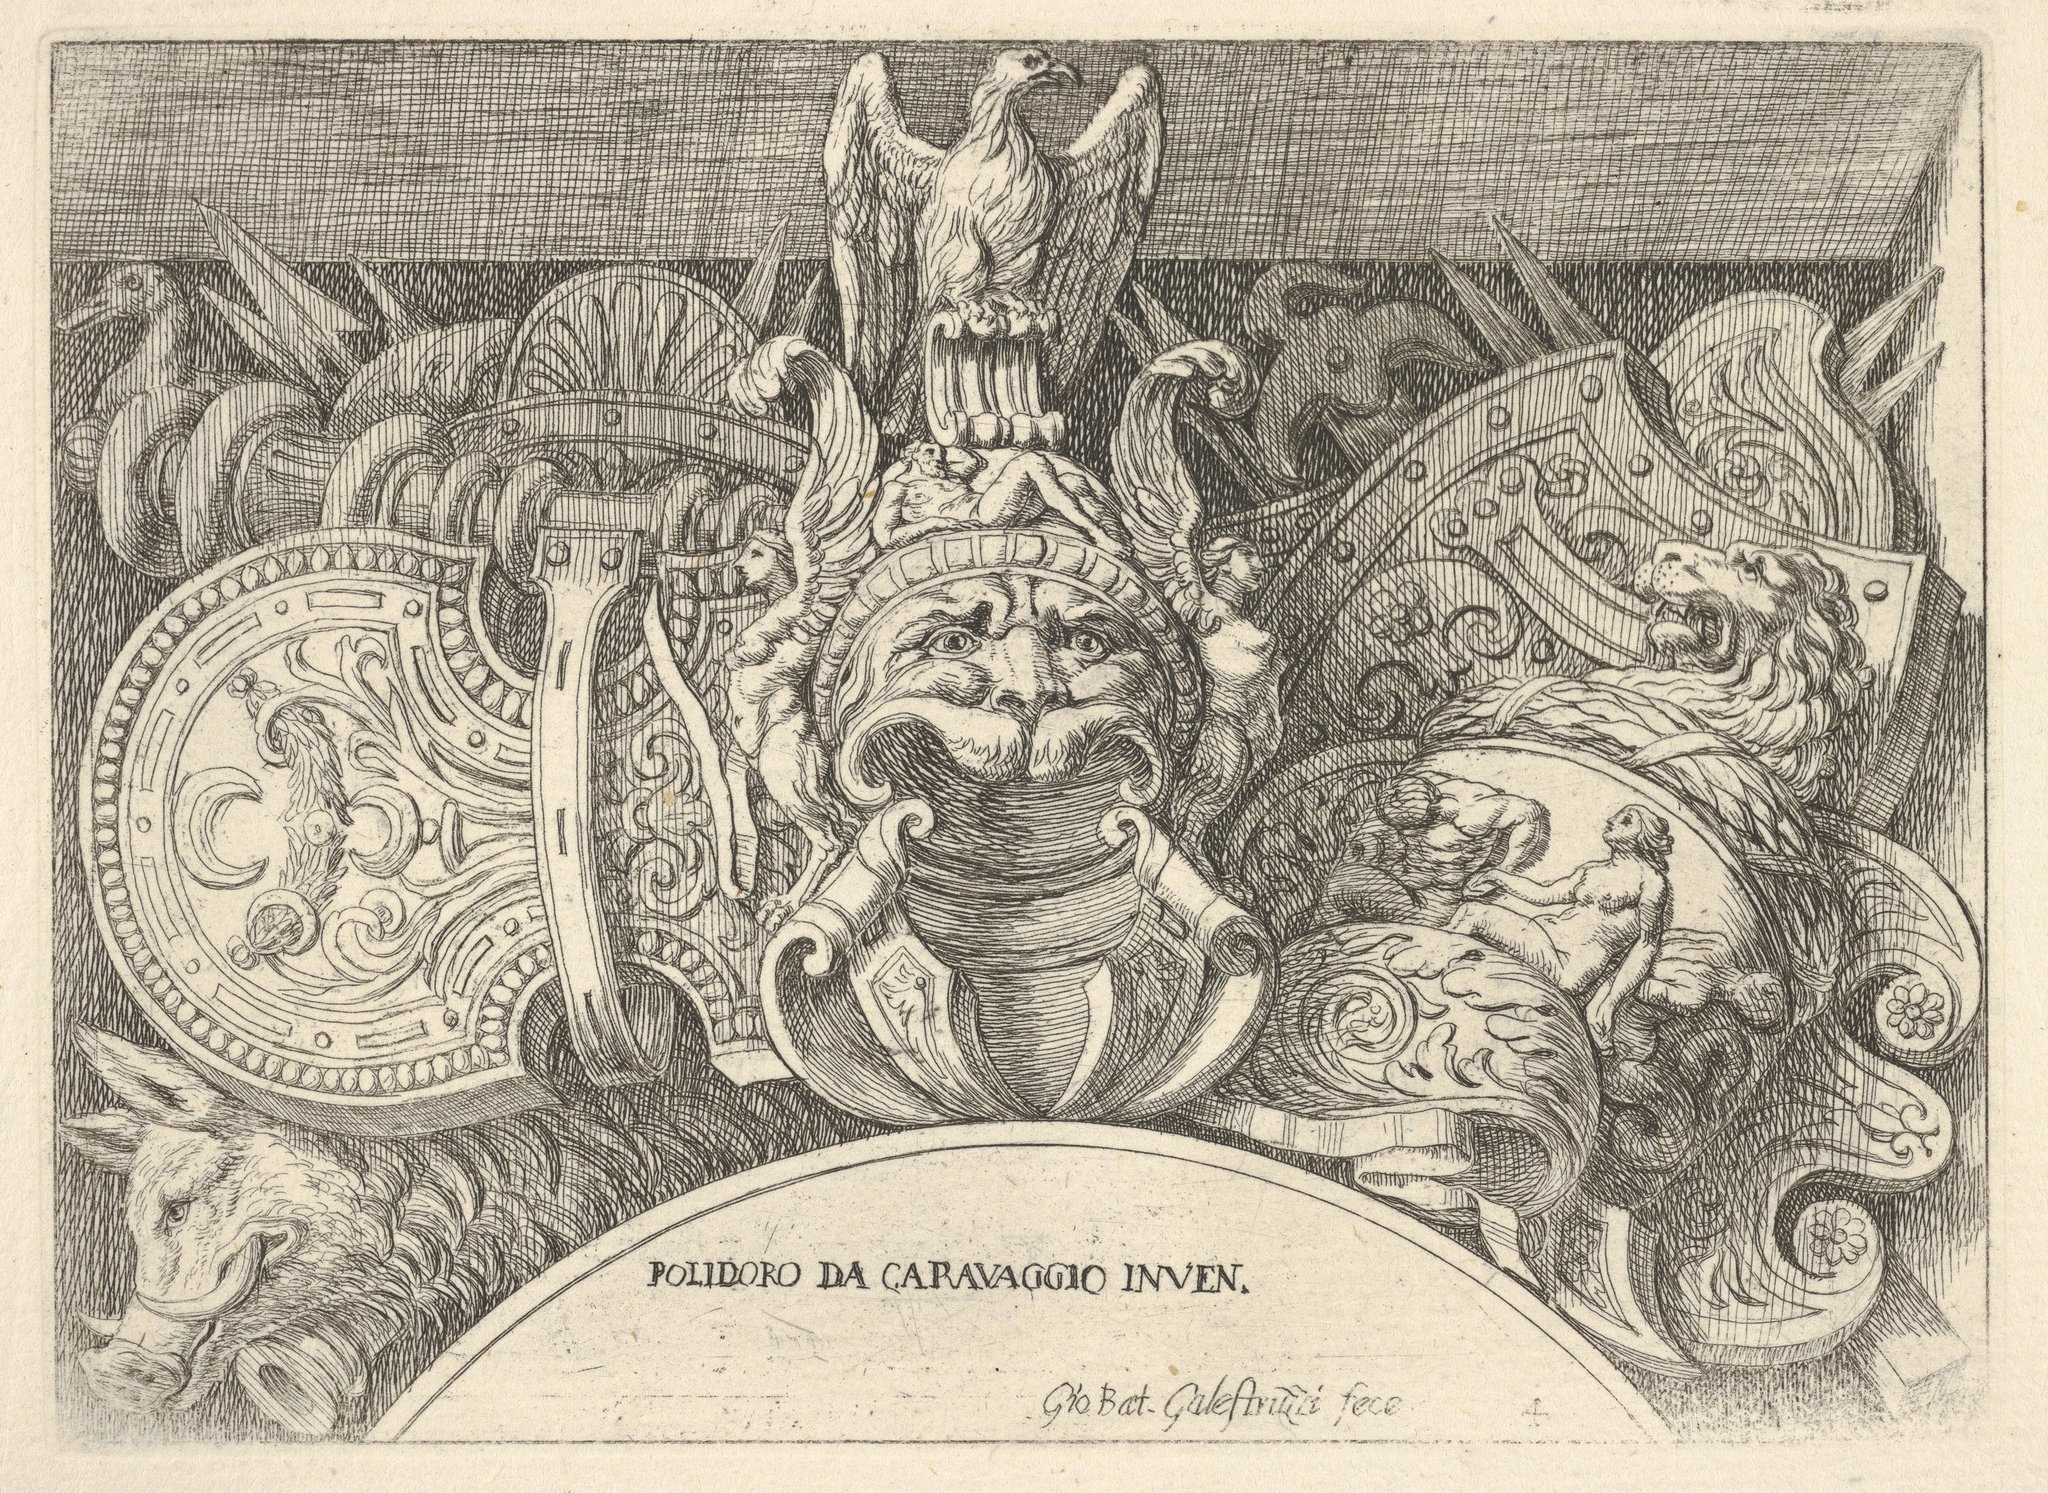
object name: print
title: Plate 4: trophies of Roman arms from decorations above the windows on the second floor of the Palazzo Milesi in Rome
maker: giovanni battista galestruzzi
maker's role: artist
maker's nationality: italian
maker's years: 1615-1669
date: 1656-1658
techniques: etching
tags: eagles,lions